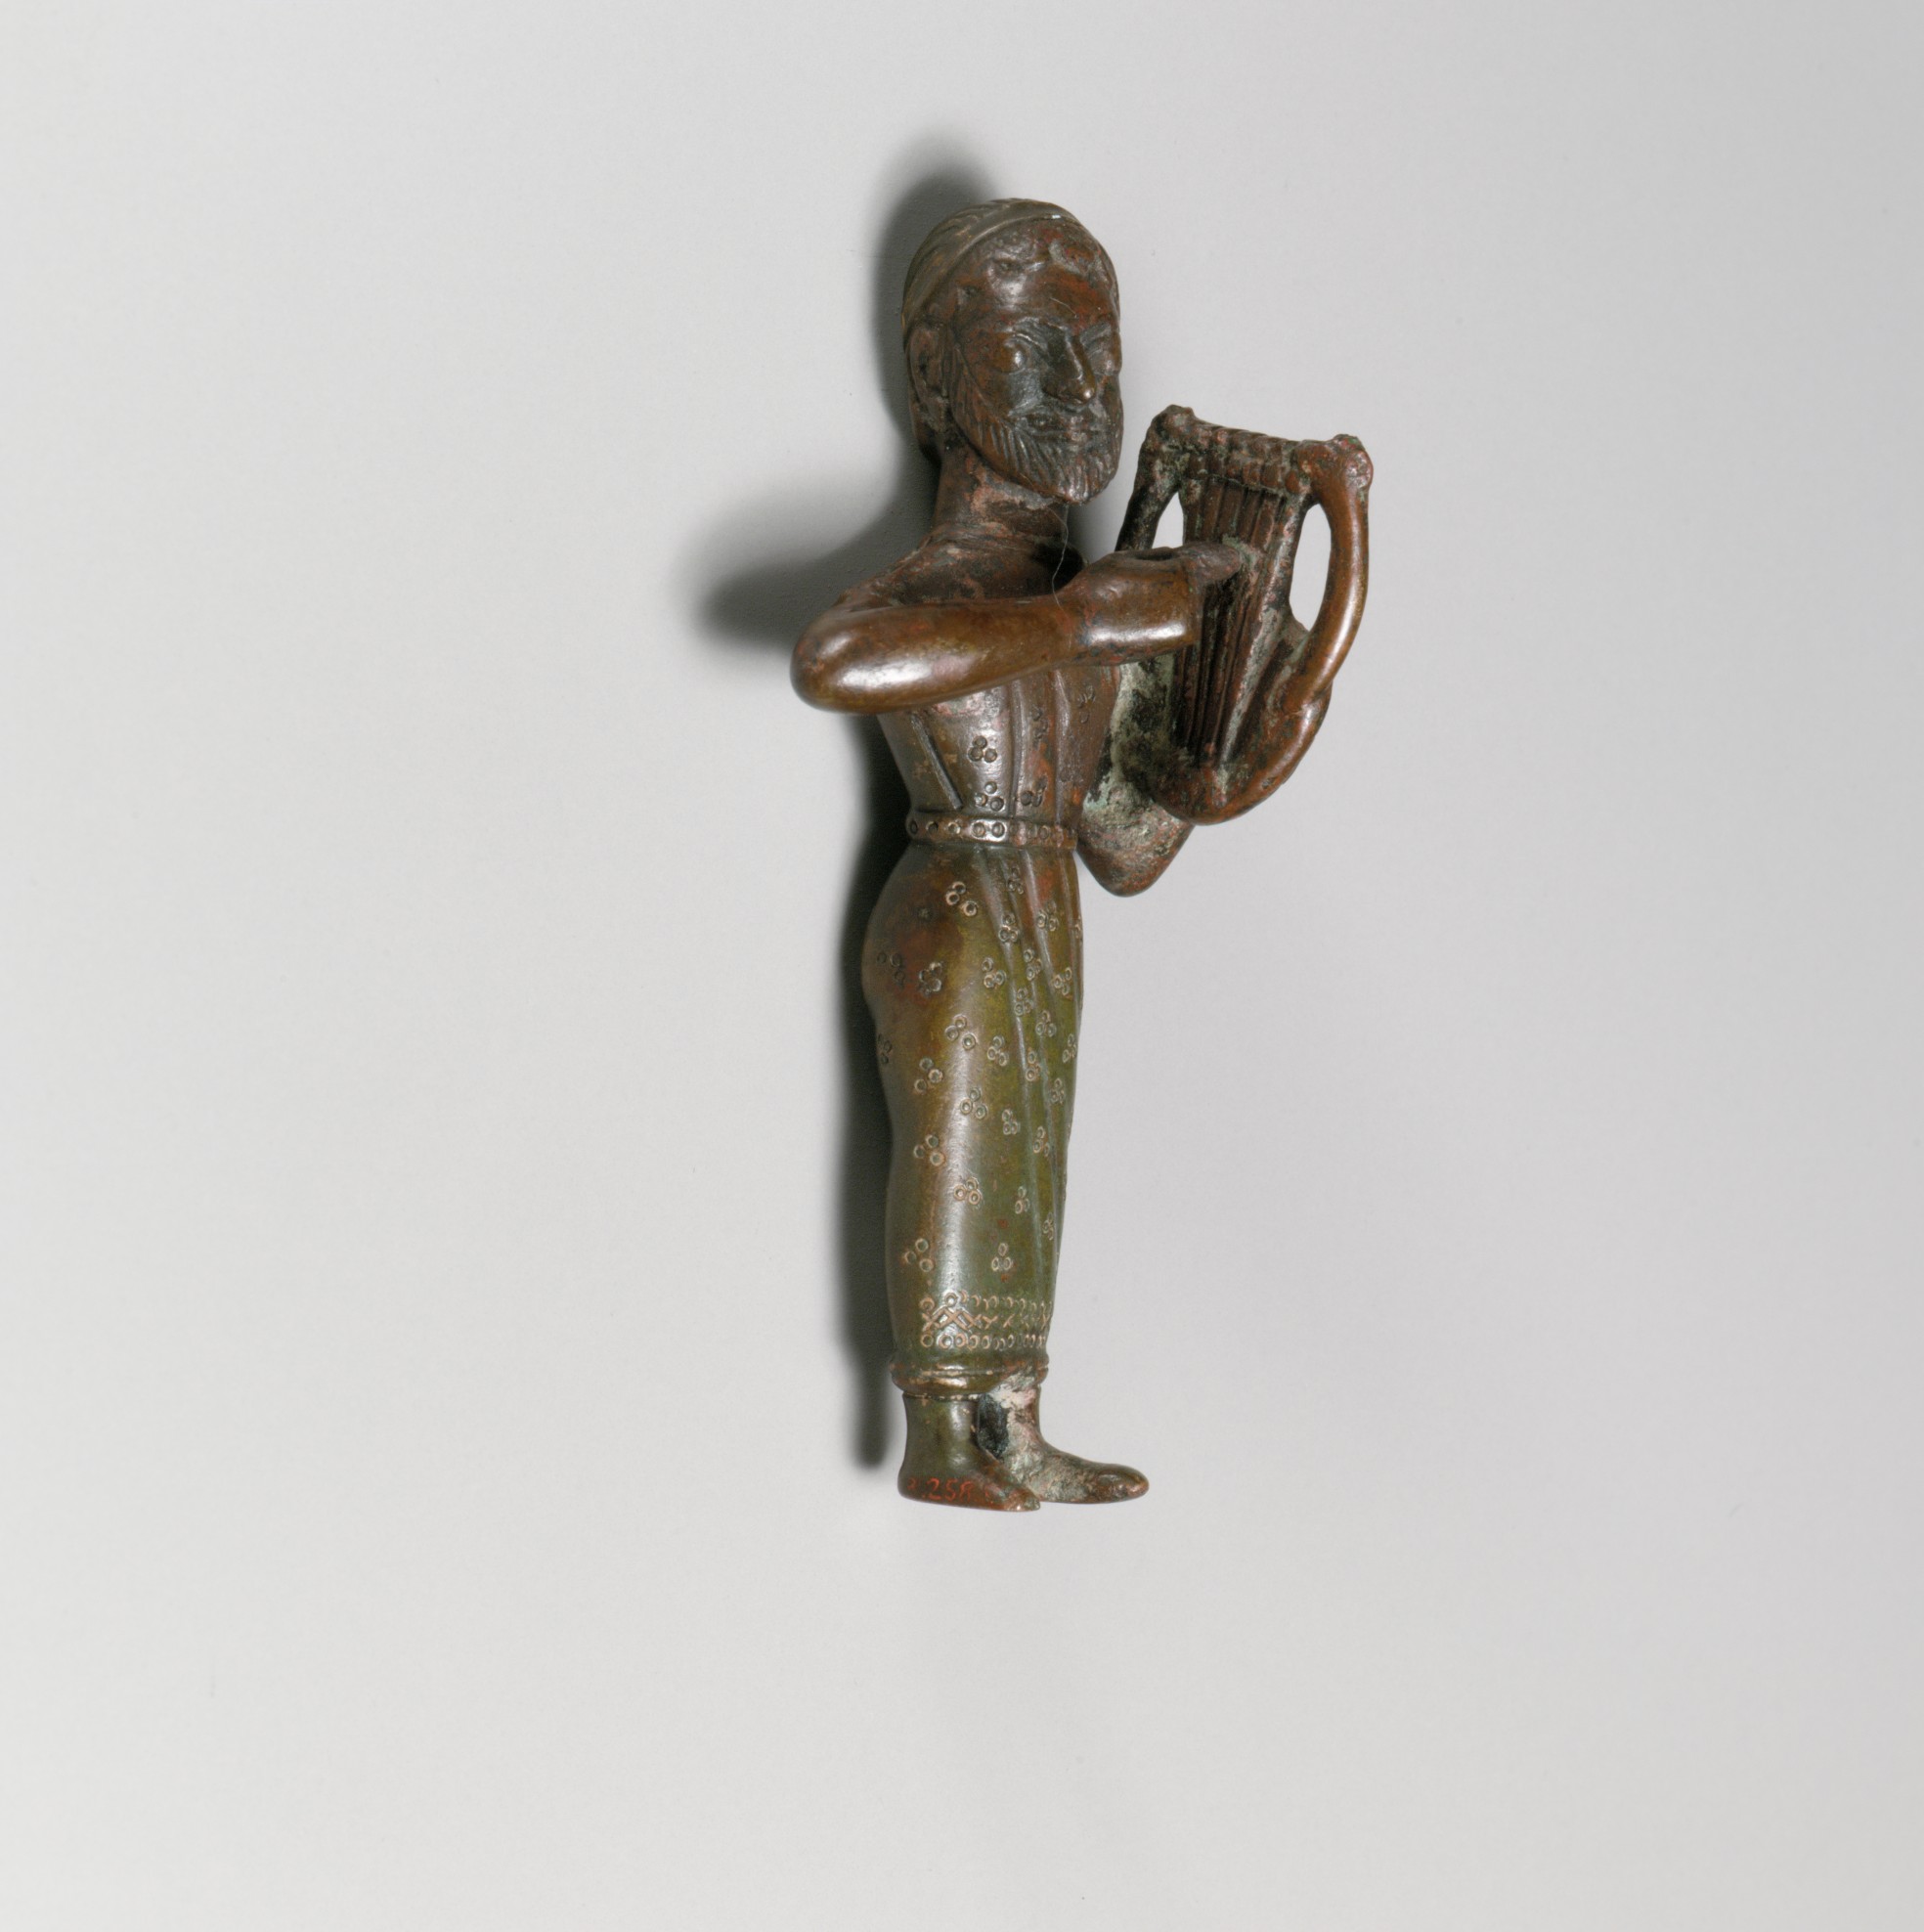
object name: statuette of a harp lyre player, male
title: Statuette of a harp (lyre) player, male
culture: greek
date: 550-526 BCE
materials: bronze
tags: men,harps,musicians